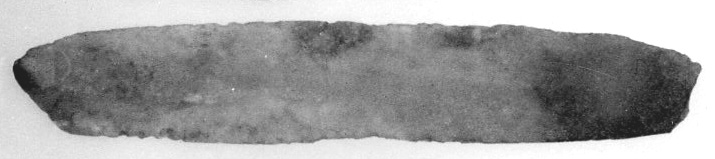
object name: knife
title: Blade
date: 1295-1070 BCE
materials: stone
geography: egypt